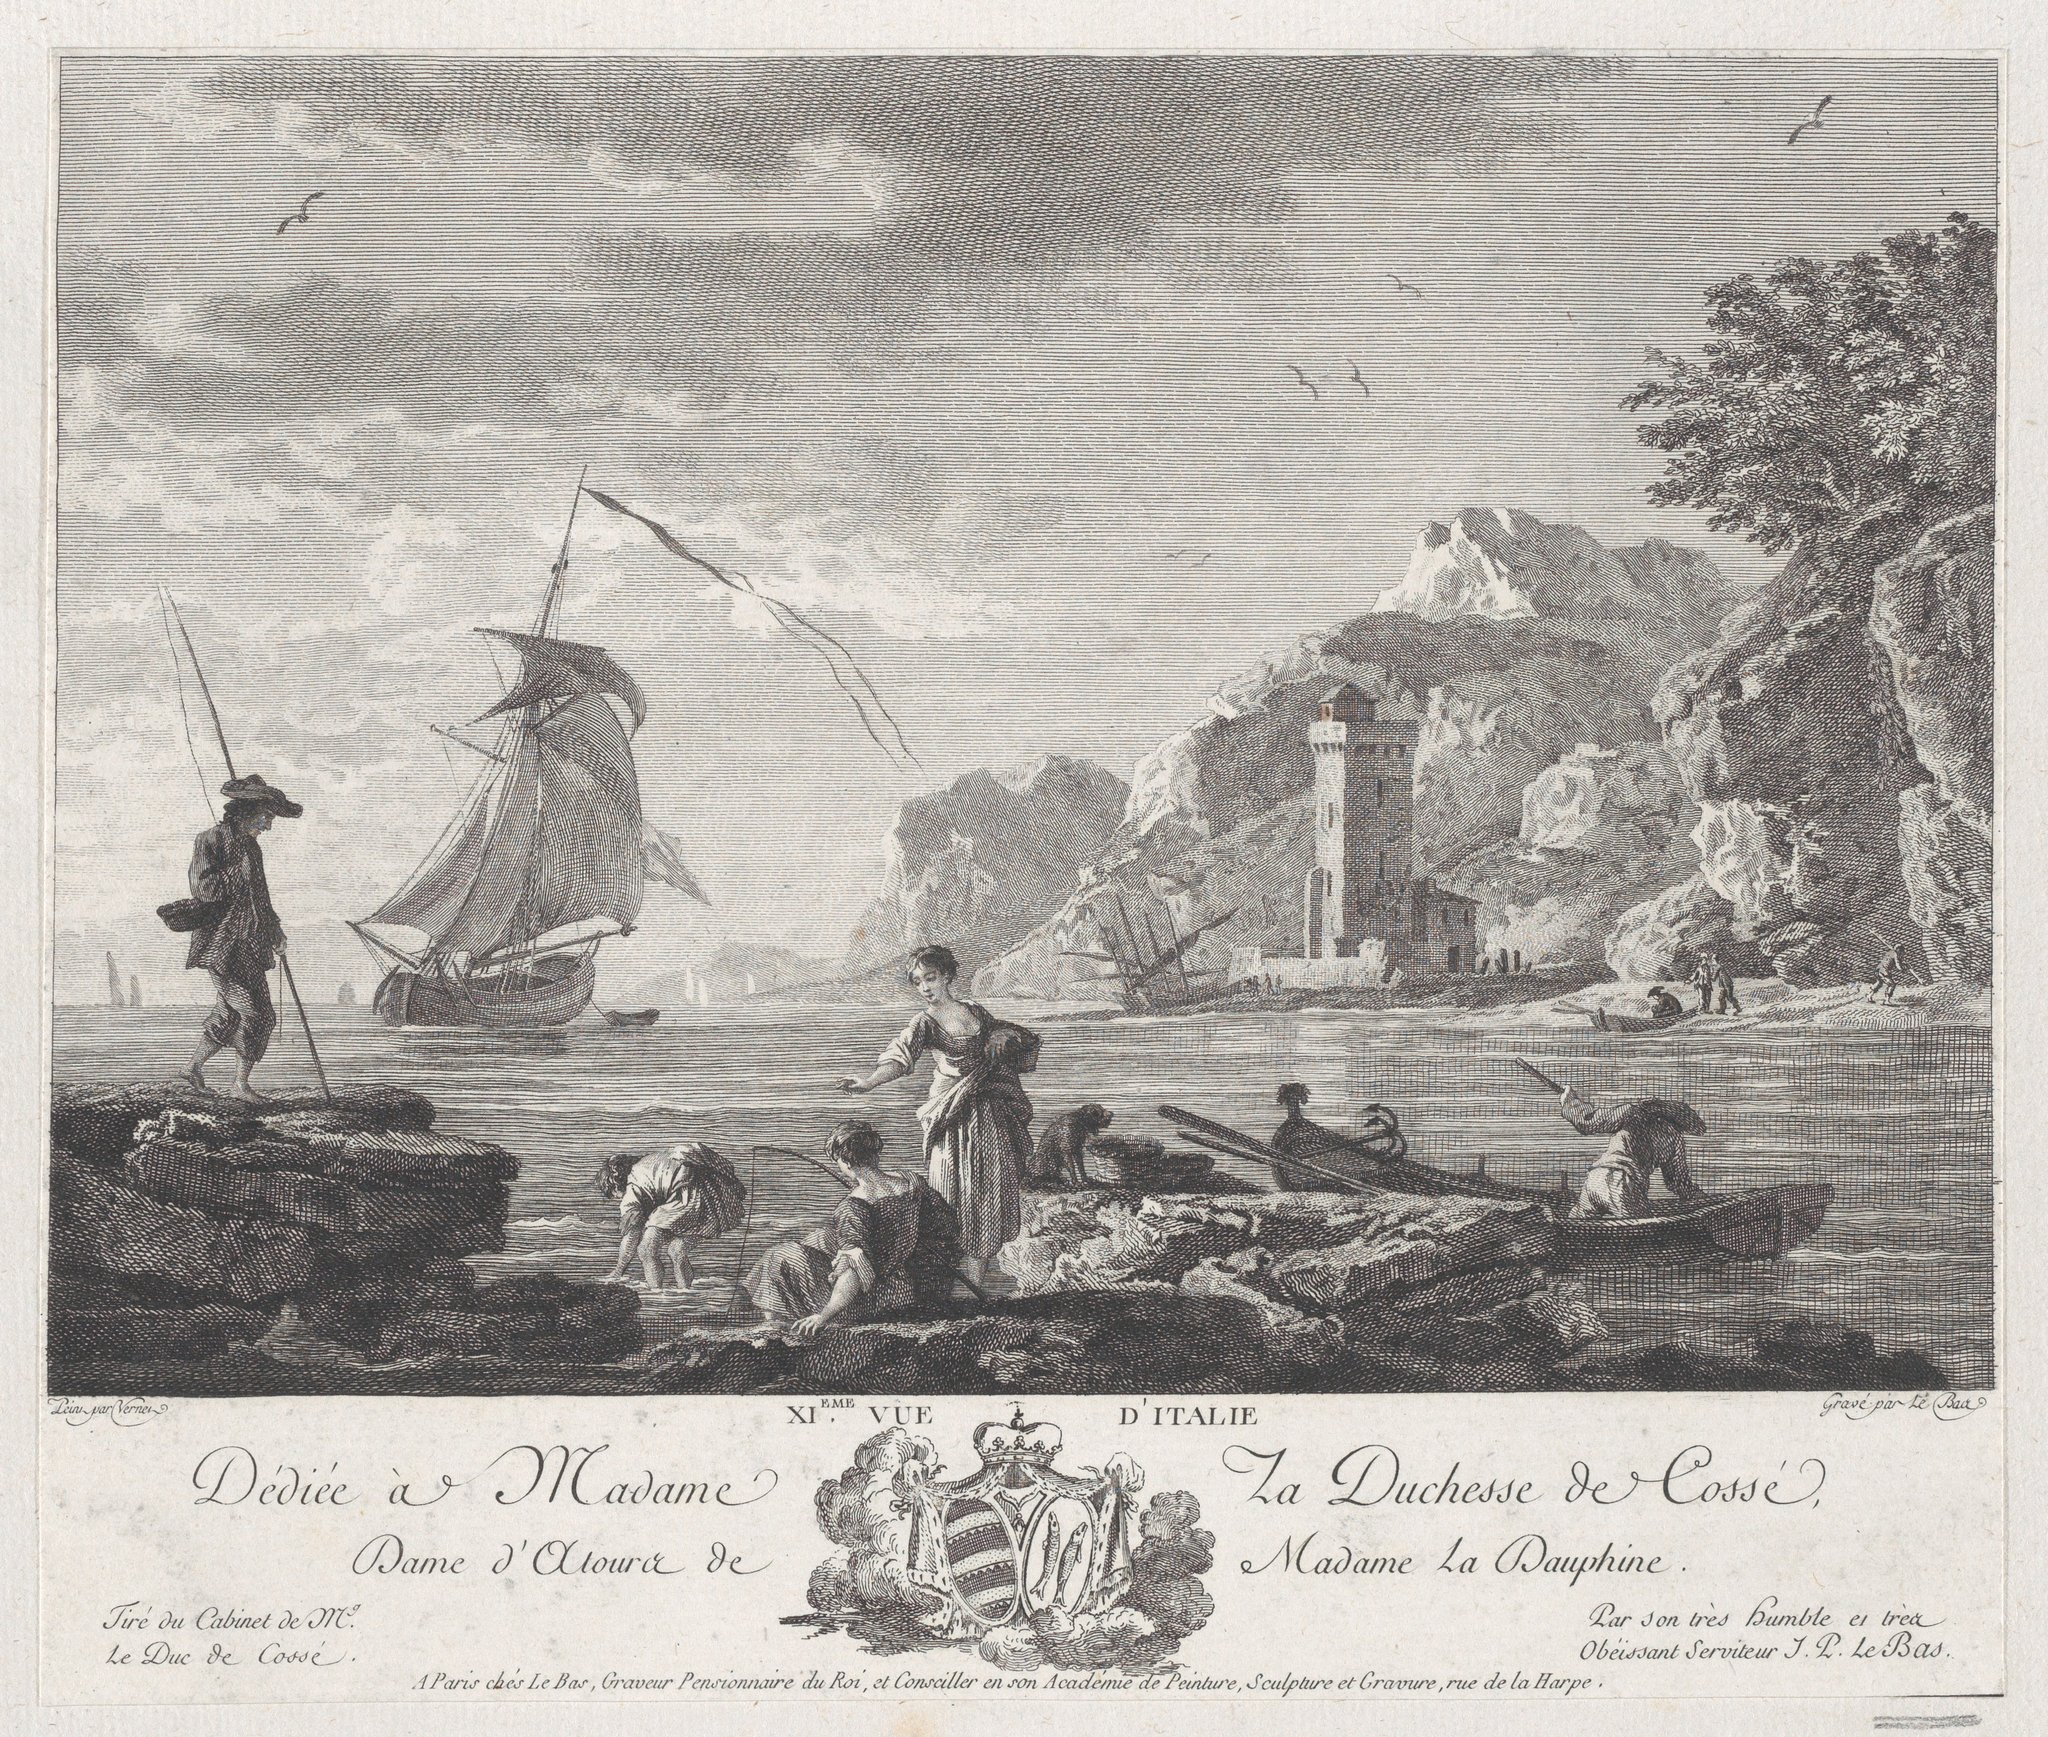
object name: print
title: Eleventh View of Italy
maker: joseph vernet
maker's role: artist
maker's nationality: french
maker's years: 1714-1789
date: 1765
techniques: engraving